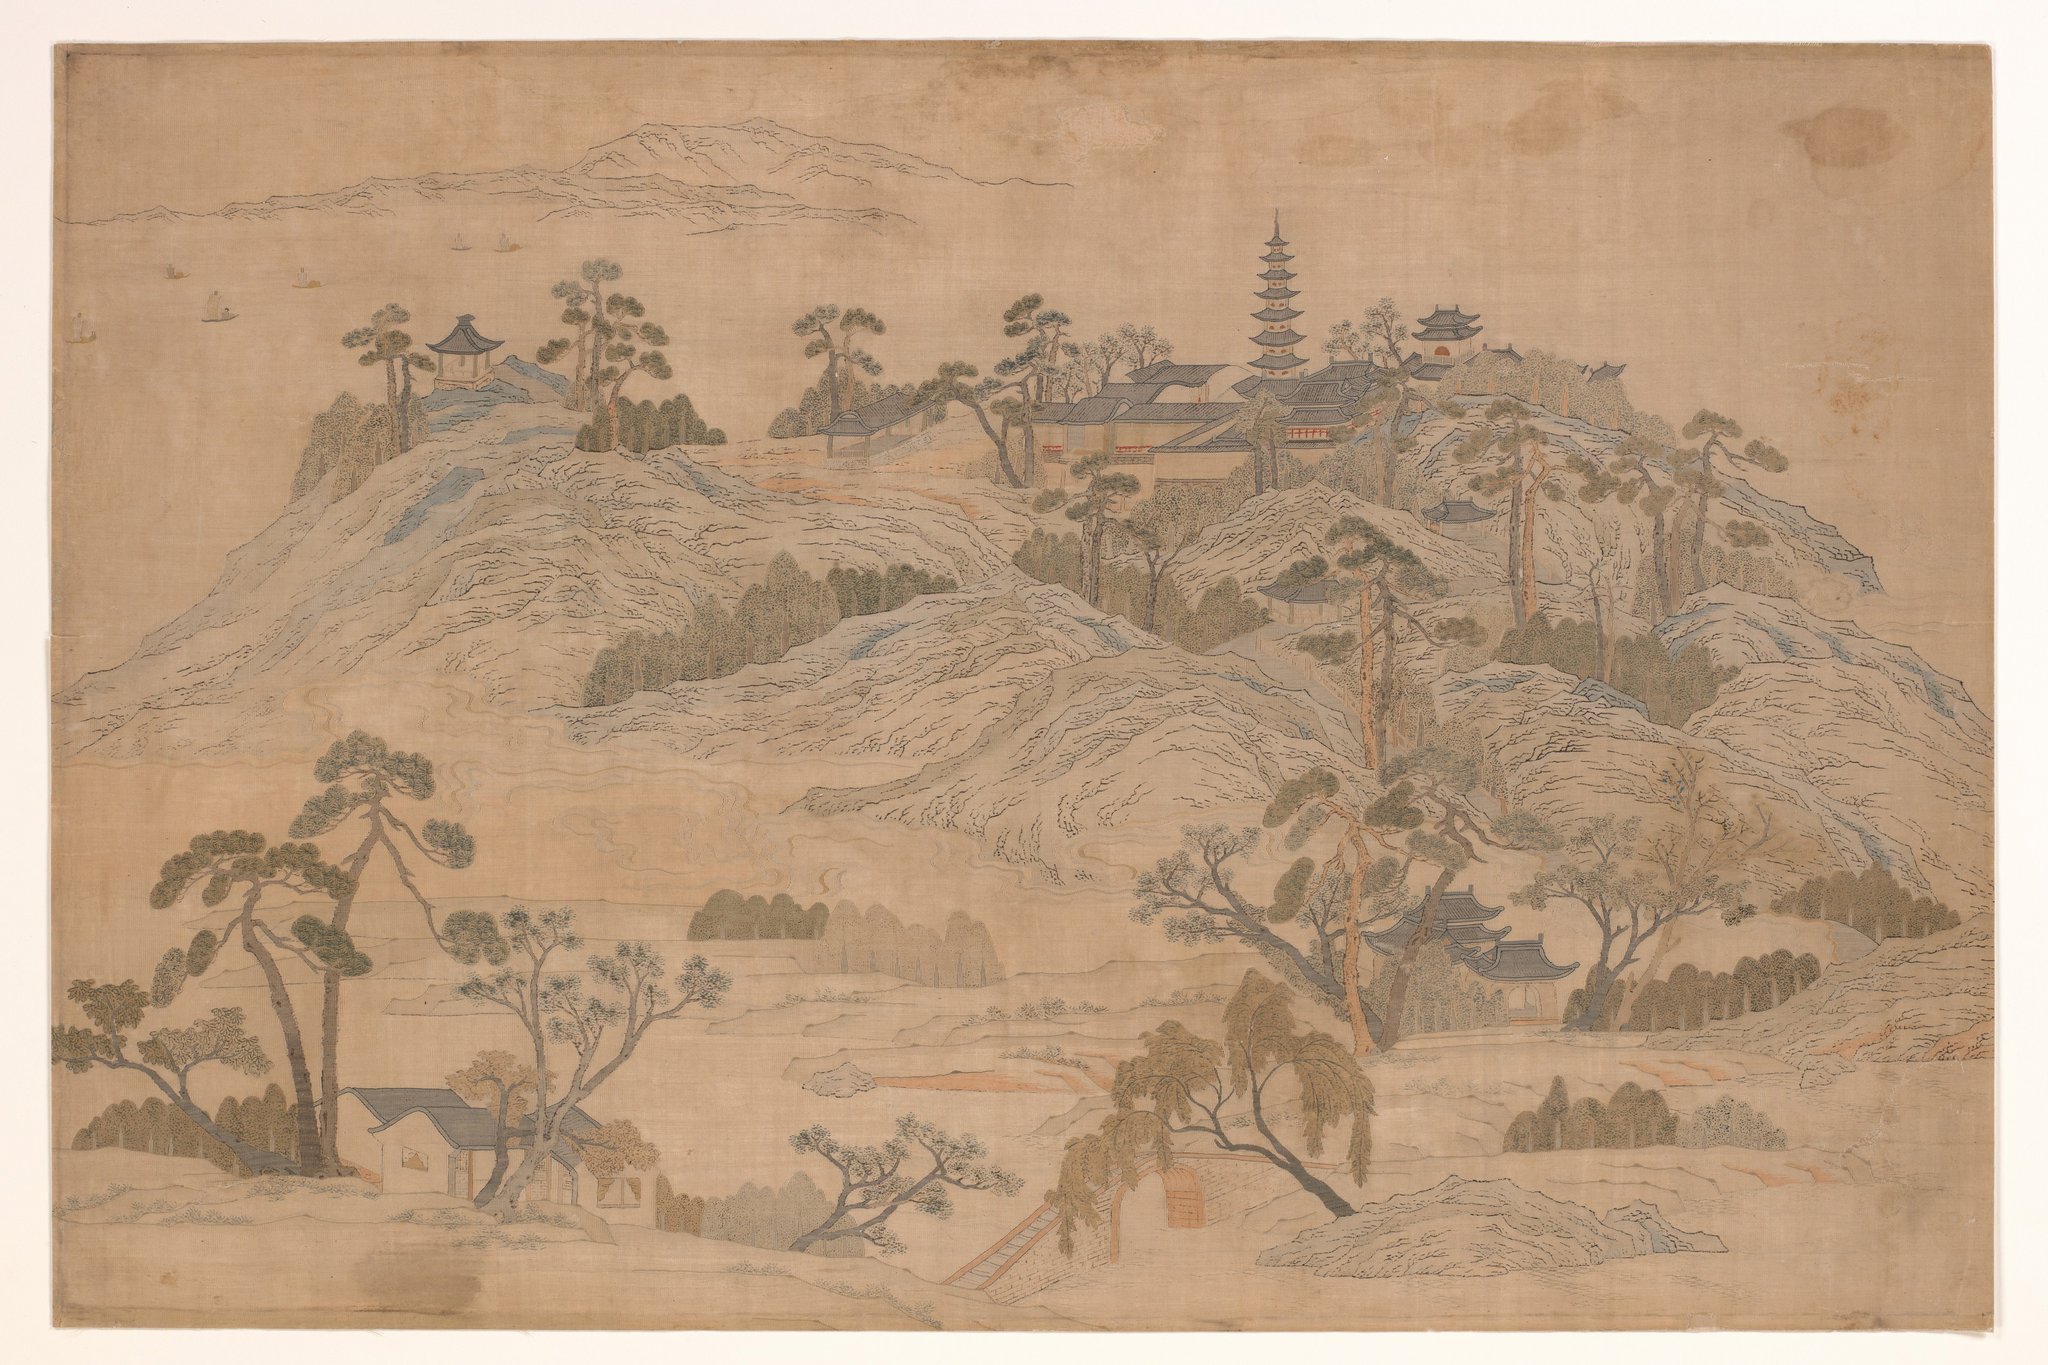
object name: panel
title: Panel with Landscape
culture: chinese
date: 1767-1800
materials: ink, metal thread, silk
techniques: tapestry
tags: houses,landscapes,trees